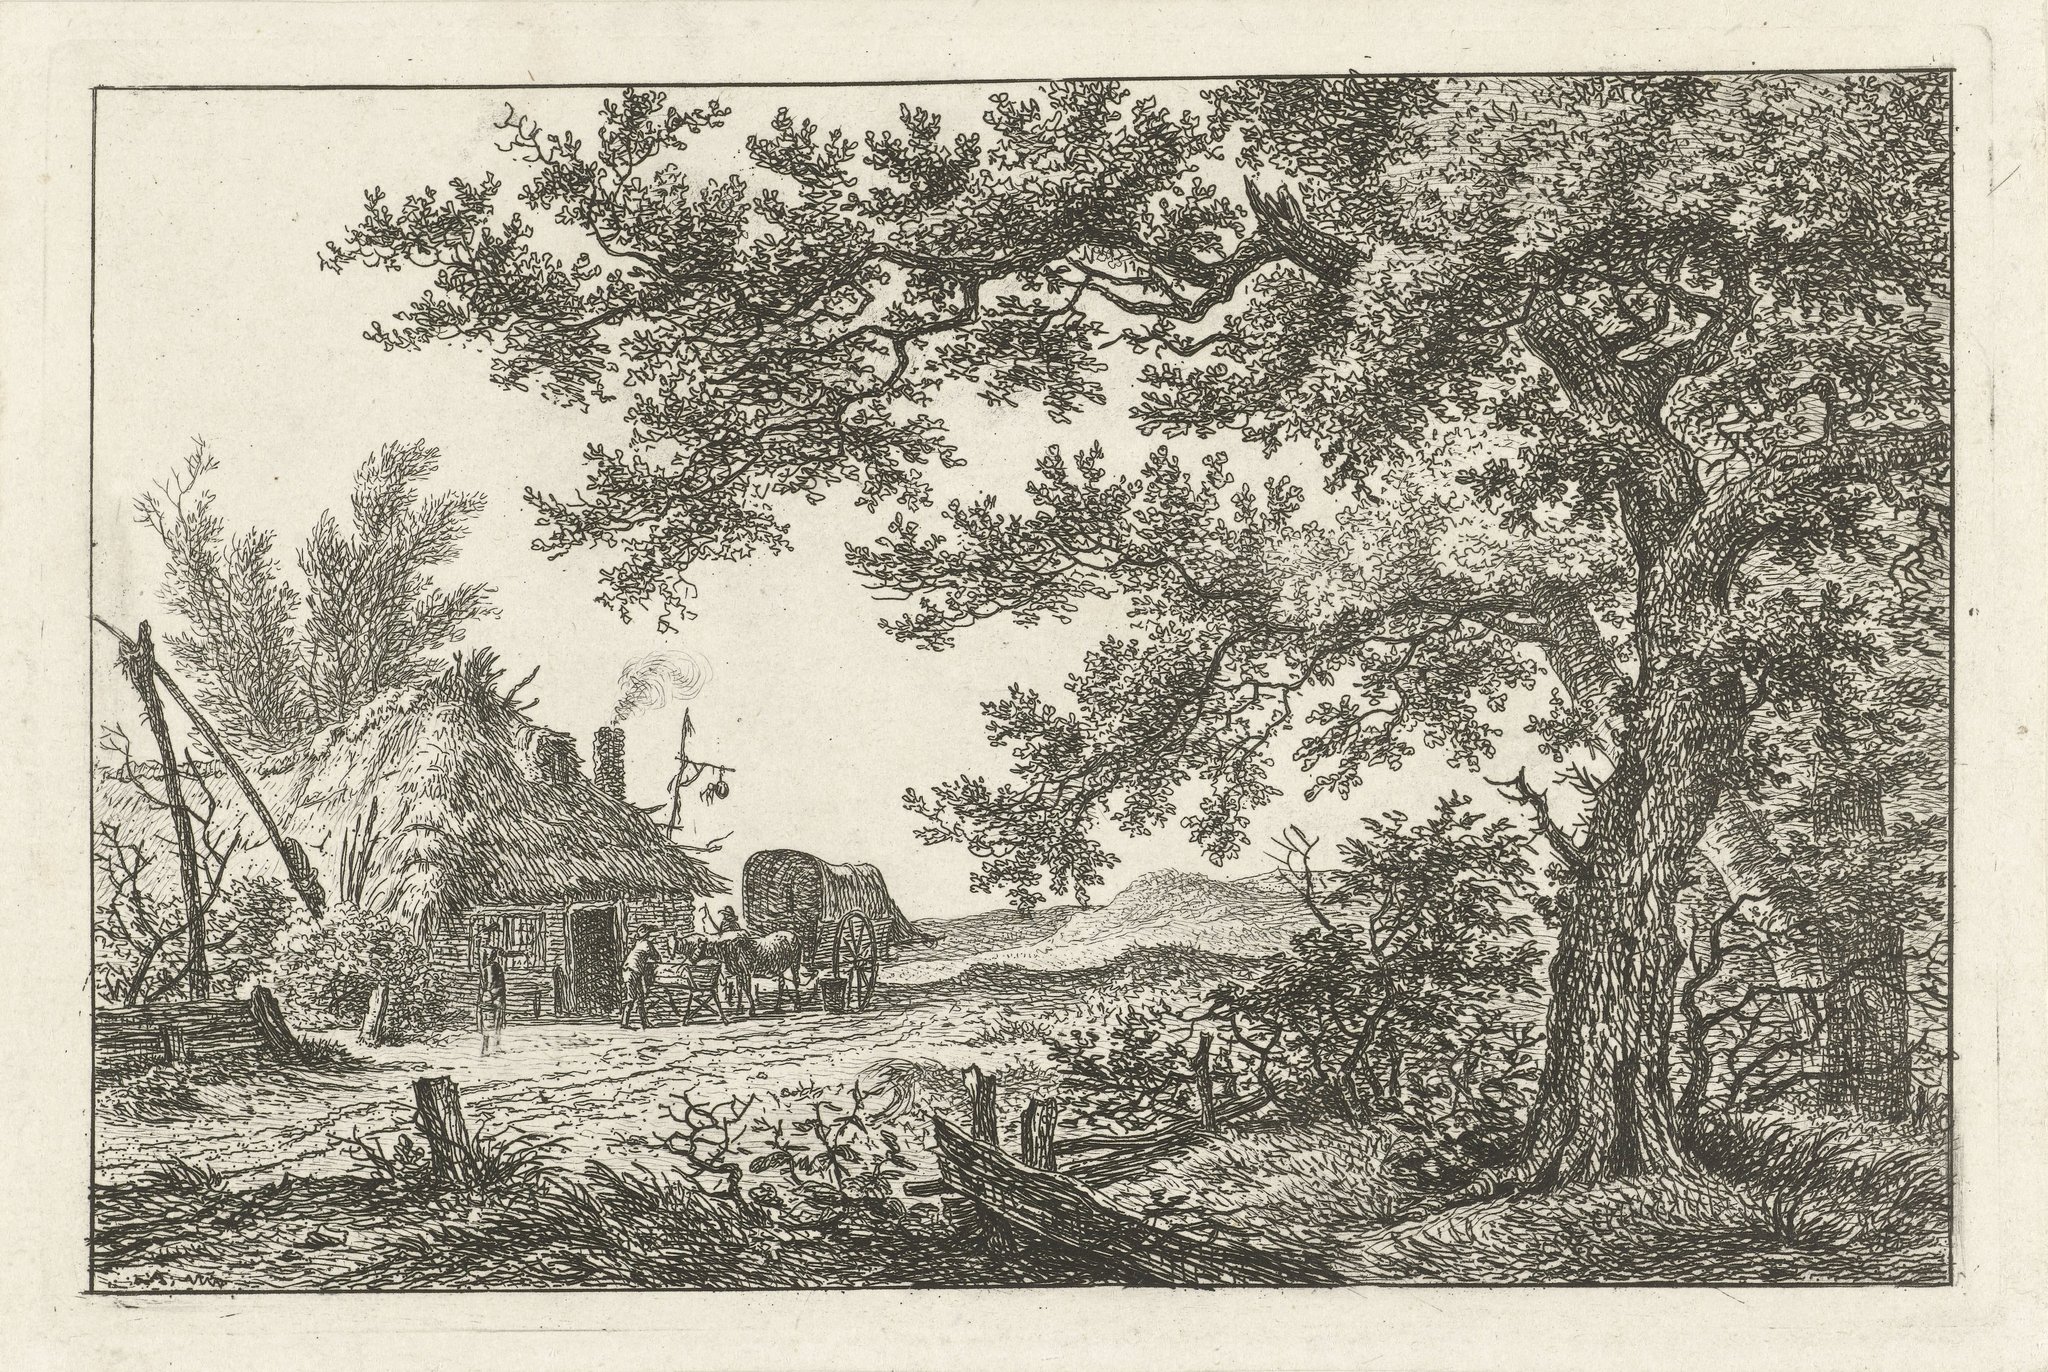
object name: print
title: Huifkar bij boerderij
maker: hermanus fock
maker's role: conservator, draughtsman, painter, print maker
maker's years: 1766-1822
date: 1781-1822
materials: paper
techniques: etching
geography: amsterdam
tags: landscapes (+ landscape with figures, staffage), (farm) wagon, freight wagon, cart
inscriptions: collector's mark: Lugt 2228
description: Een landschap met op de voorgrond een grote boom. Bij een huis met een rieten dak staat een huifkar.